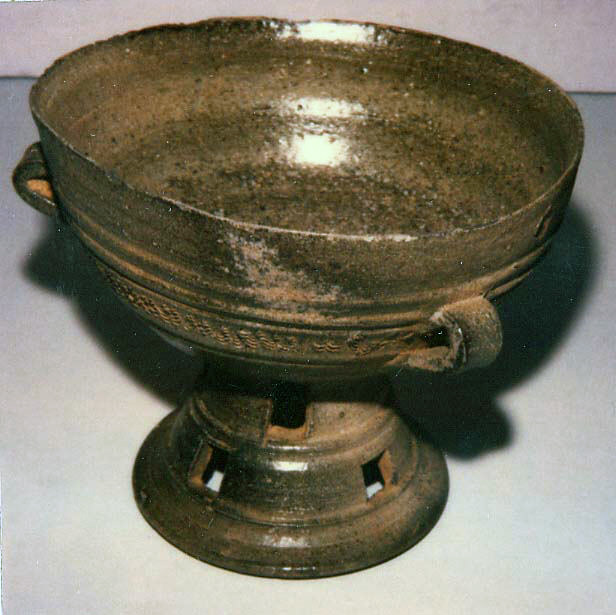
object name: bowl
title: Pedestalled Bowl with Three Handles and Combed Design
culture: korean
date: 401-700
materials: wood, glaze, pottery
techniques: firing